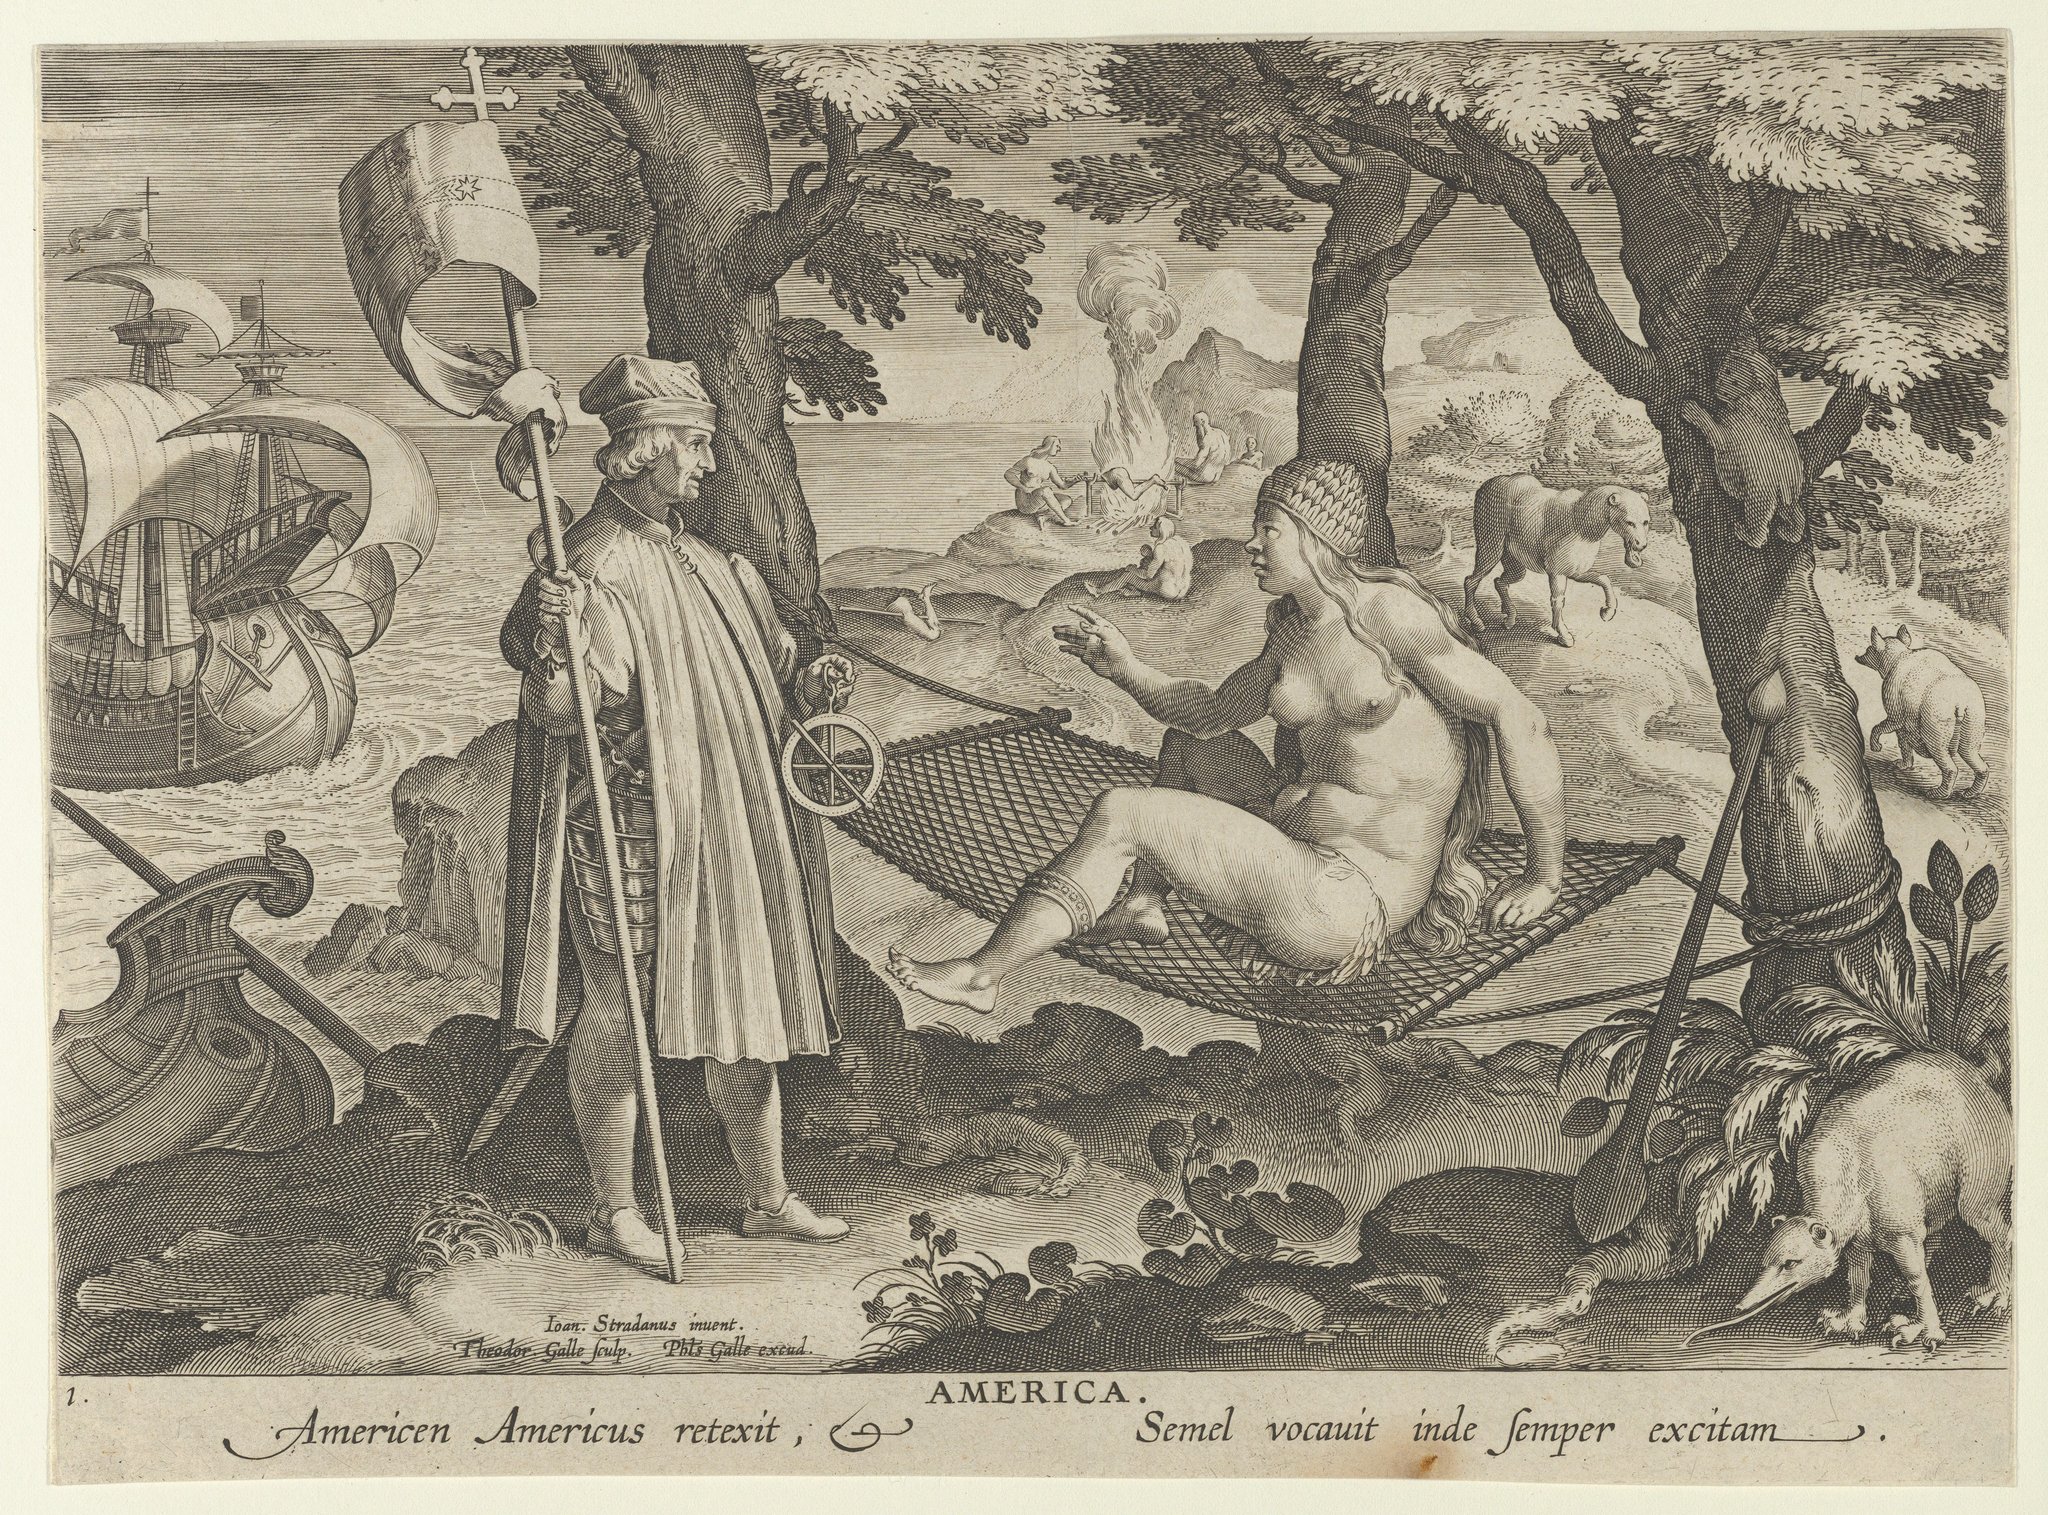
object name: print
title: Allegory of America, from New Inventions of Modern Times (Nova Reperta), plate 1 of 19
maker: theodoor galle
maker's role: artist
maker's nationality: netherlandish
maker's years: 1571-1633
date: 1600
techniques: engraving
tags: animals,men,female nudes,cross,ships